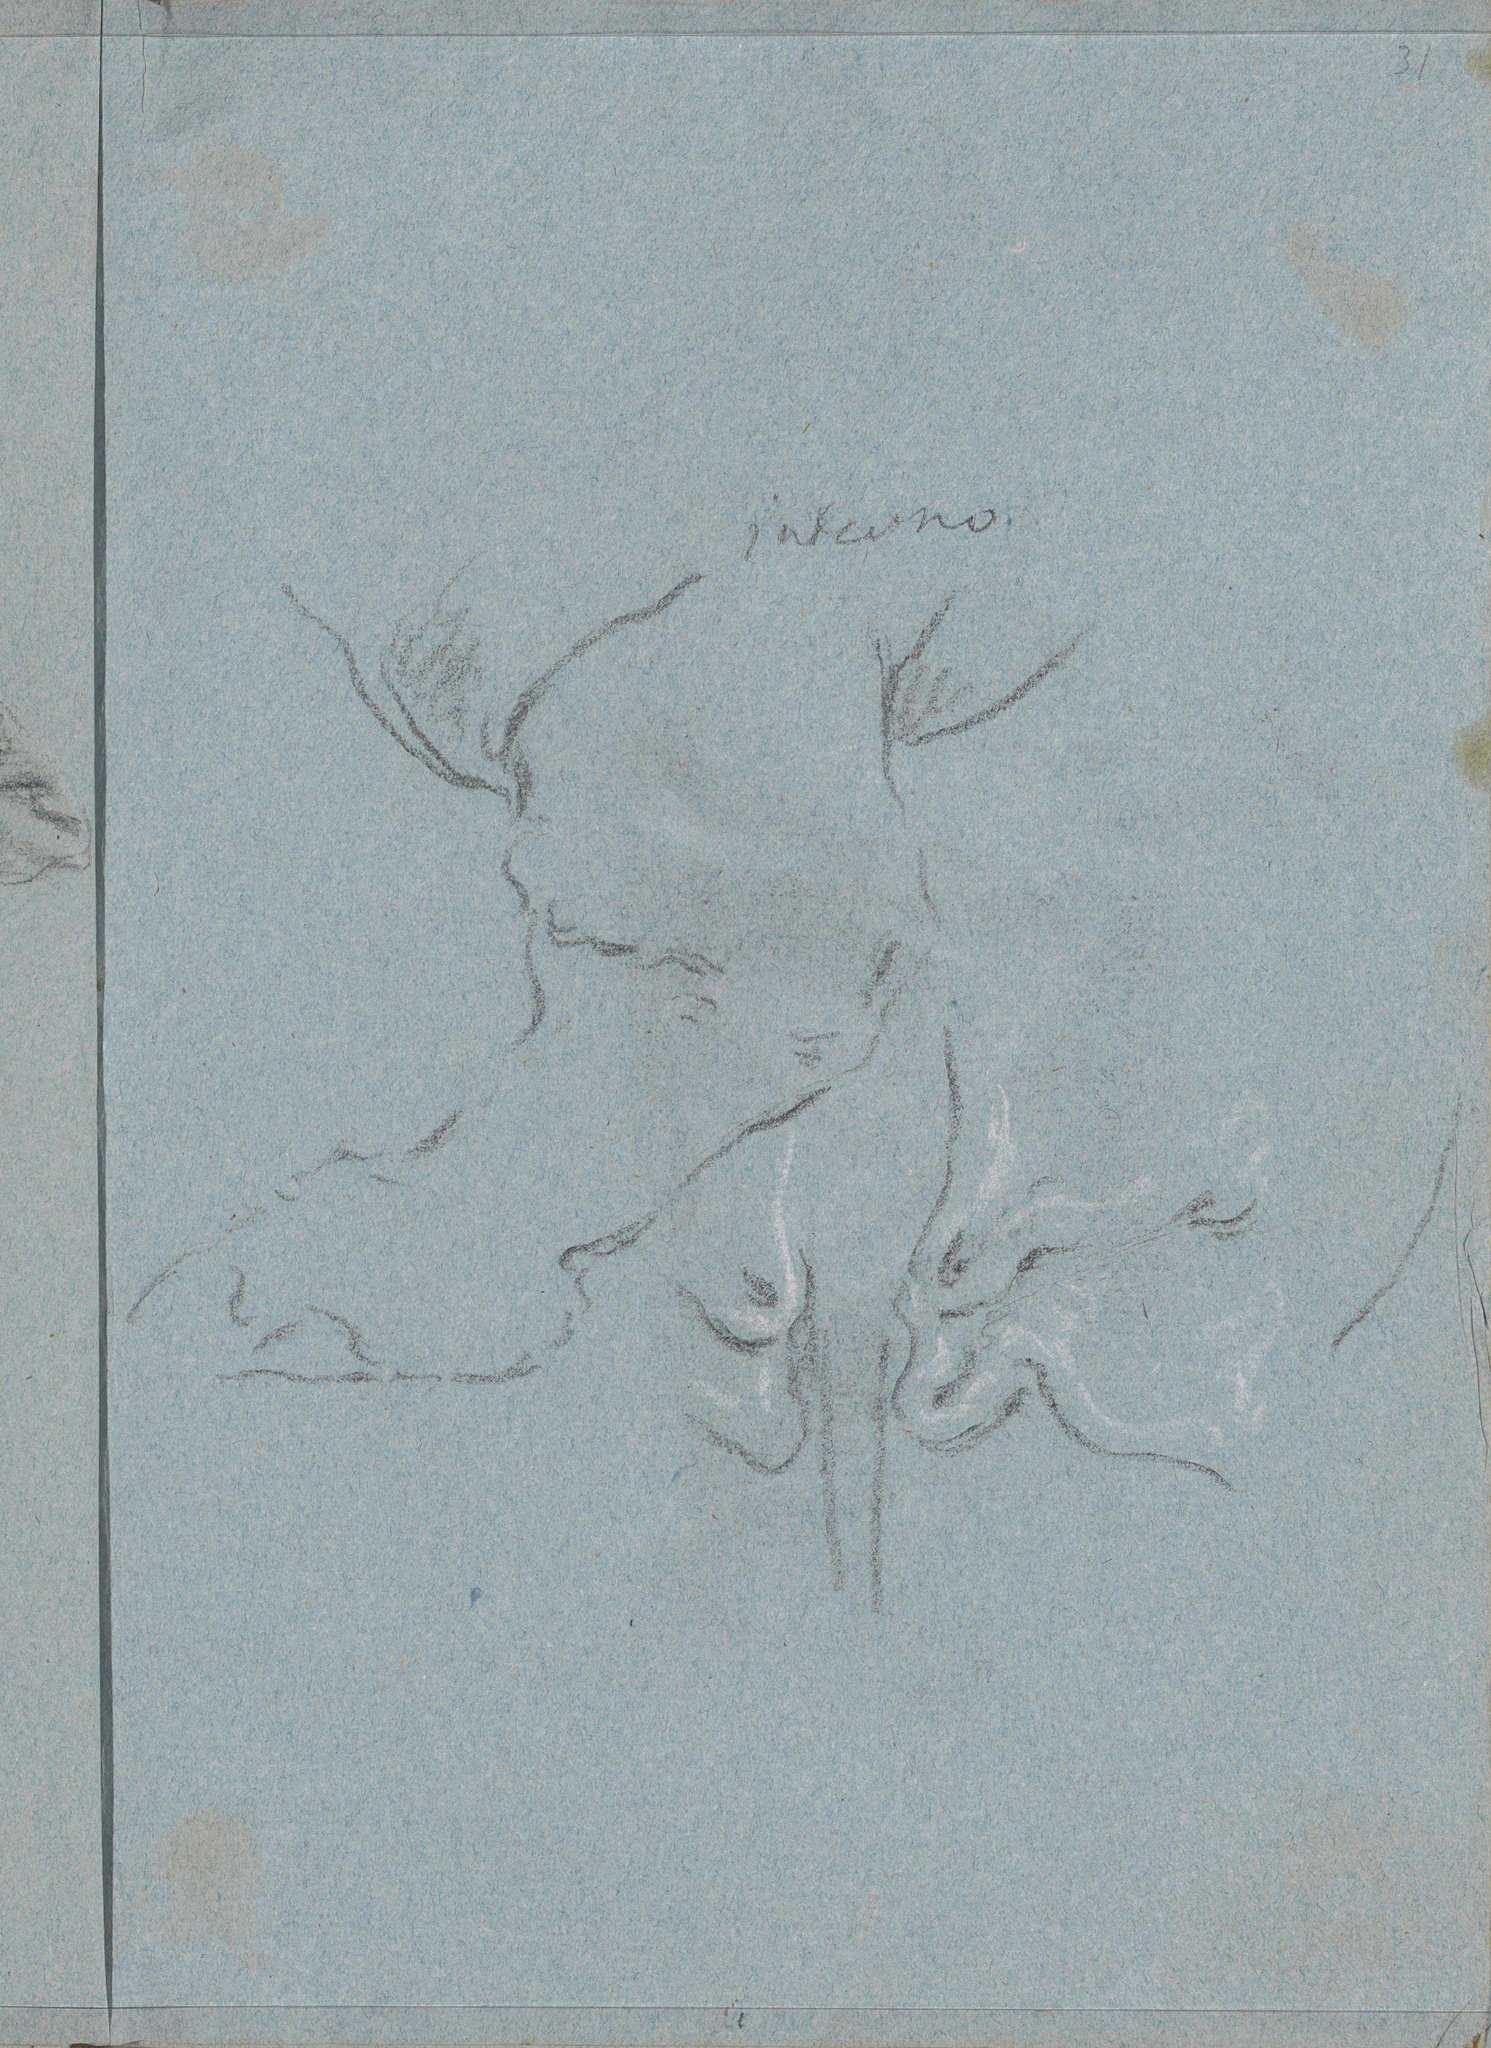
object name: sketchbook leaf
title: Studie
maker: lorenzo baldissera tiepolo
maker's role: draughtsman, print maker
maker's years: 1736-1776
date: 1751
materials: chalk, paper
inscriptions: annotation: ‘inferno’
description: Mogelijk een studie van de huid van neushoorn Clara. Bladzijde 31 uit een schetsboek met 158 bladzijden.